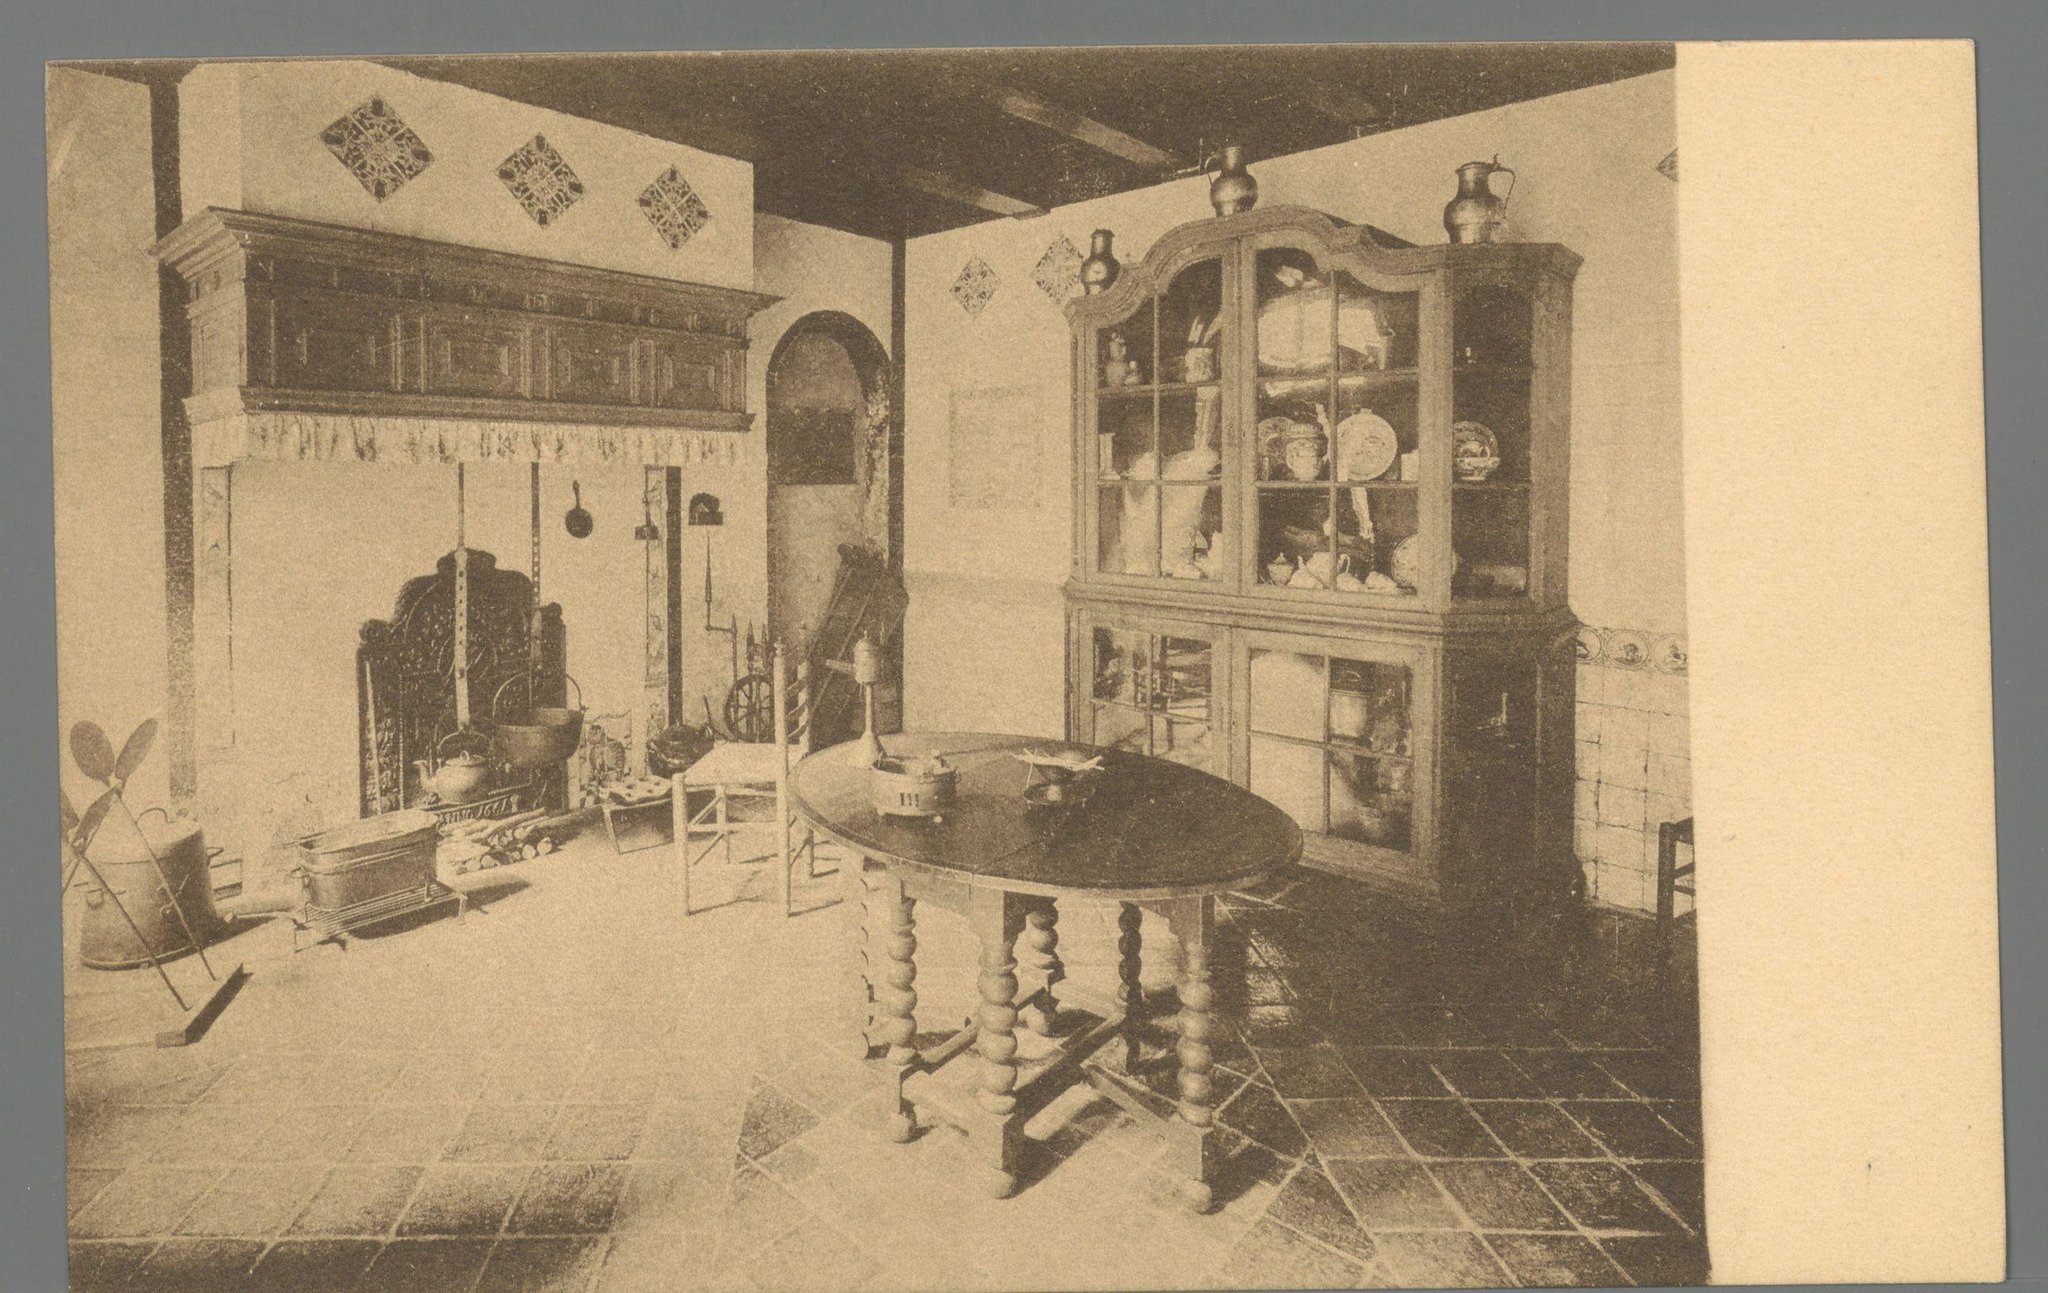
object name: ansichtkaart, prentbriefkaart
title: Stedelijk Museum te Leiden. Oud-Hollandsche Keuken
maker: Anonymous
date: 1905-1930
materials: cardboard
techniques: photograph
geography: leiden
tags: interior of the house, permanent exhibition, museum